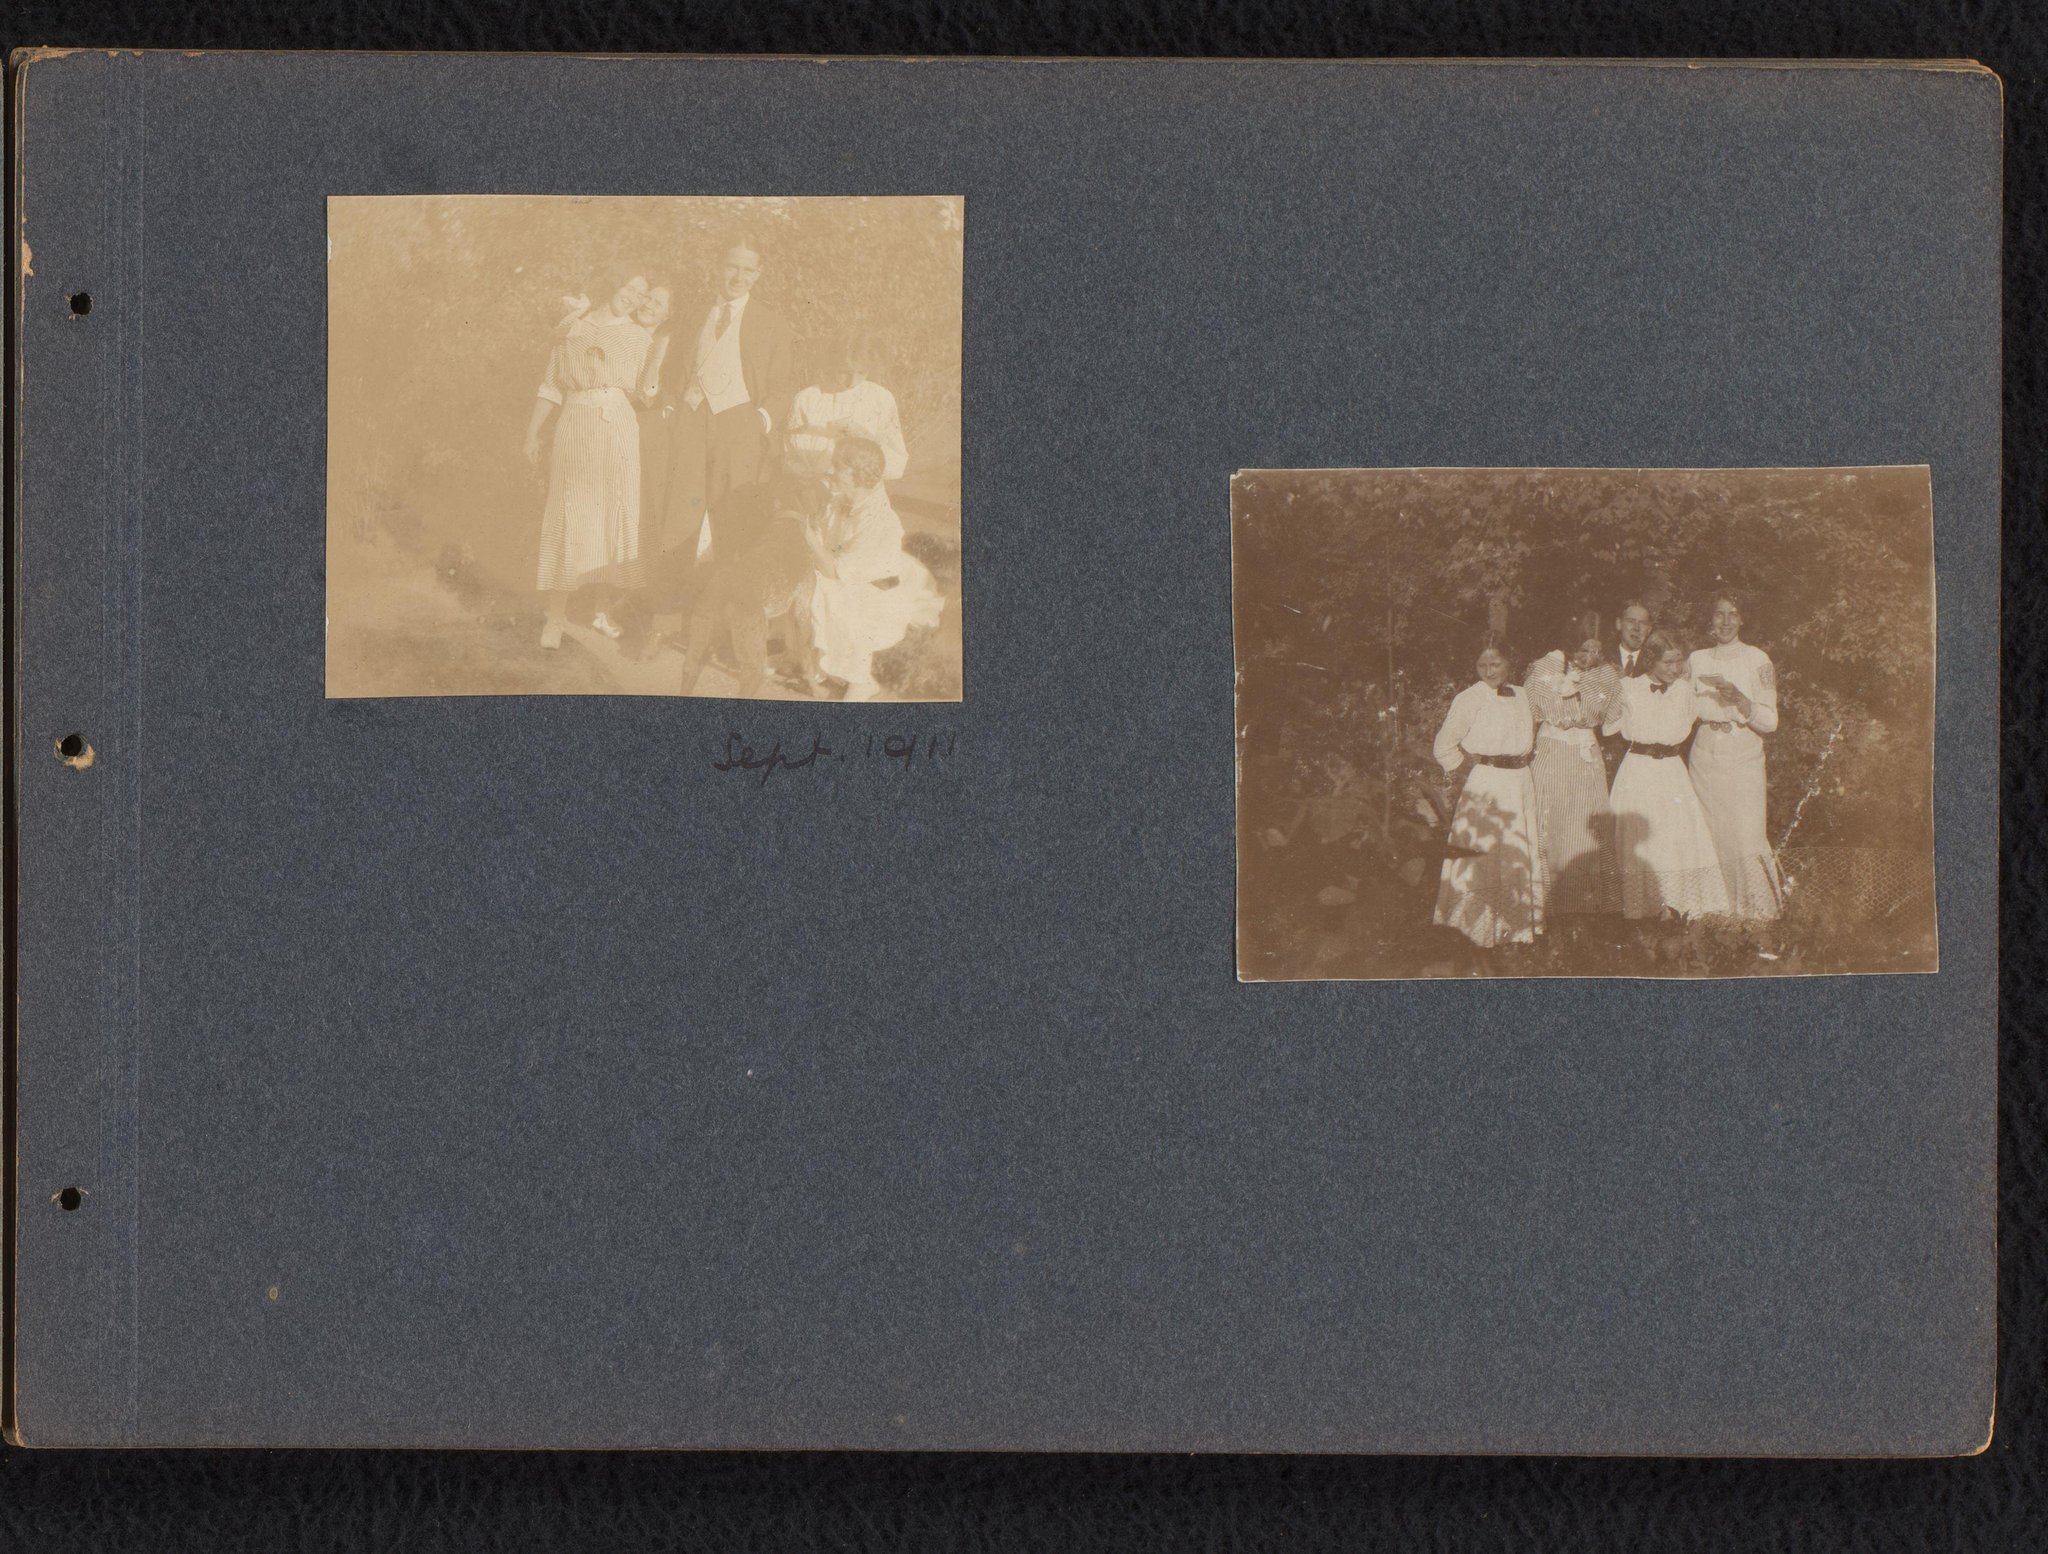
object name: photograph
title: Gezin Onnen in een tuin of park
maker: carolina frederika onnen (lien/loen)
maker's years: 1896-1983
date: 1909-1911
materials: paper, cardboard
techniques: collodion silver print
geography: hilversum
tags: emilie albertina onnen (milly), amsterdam, carolina frederika onnen (lien/loen), historical persons - bb - woman, garden, dog, anonymous historical persons portrayed in a group, in a group-portrait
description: Deze foto's zijn onderdeel van een album.